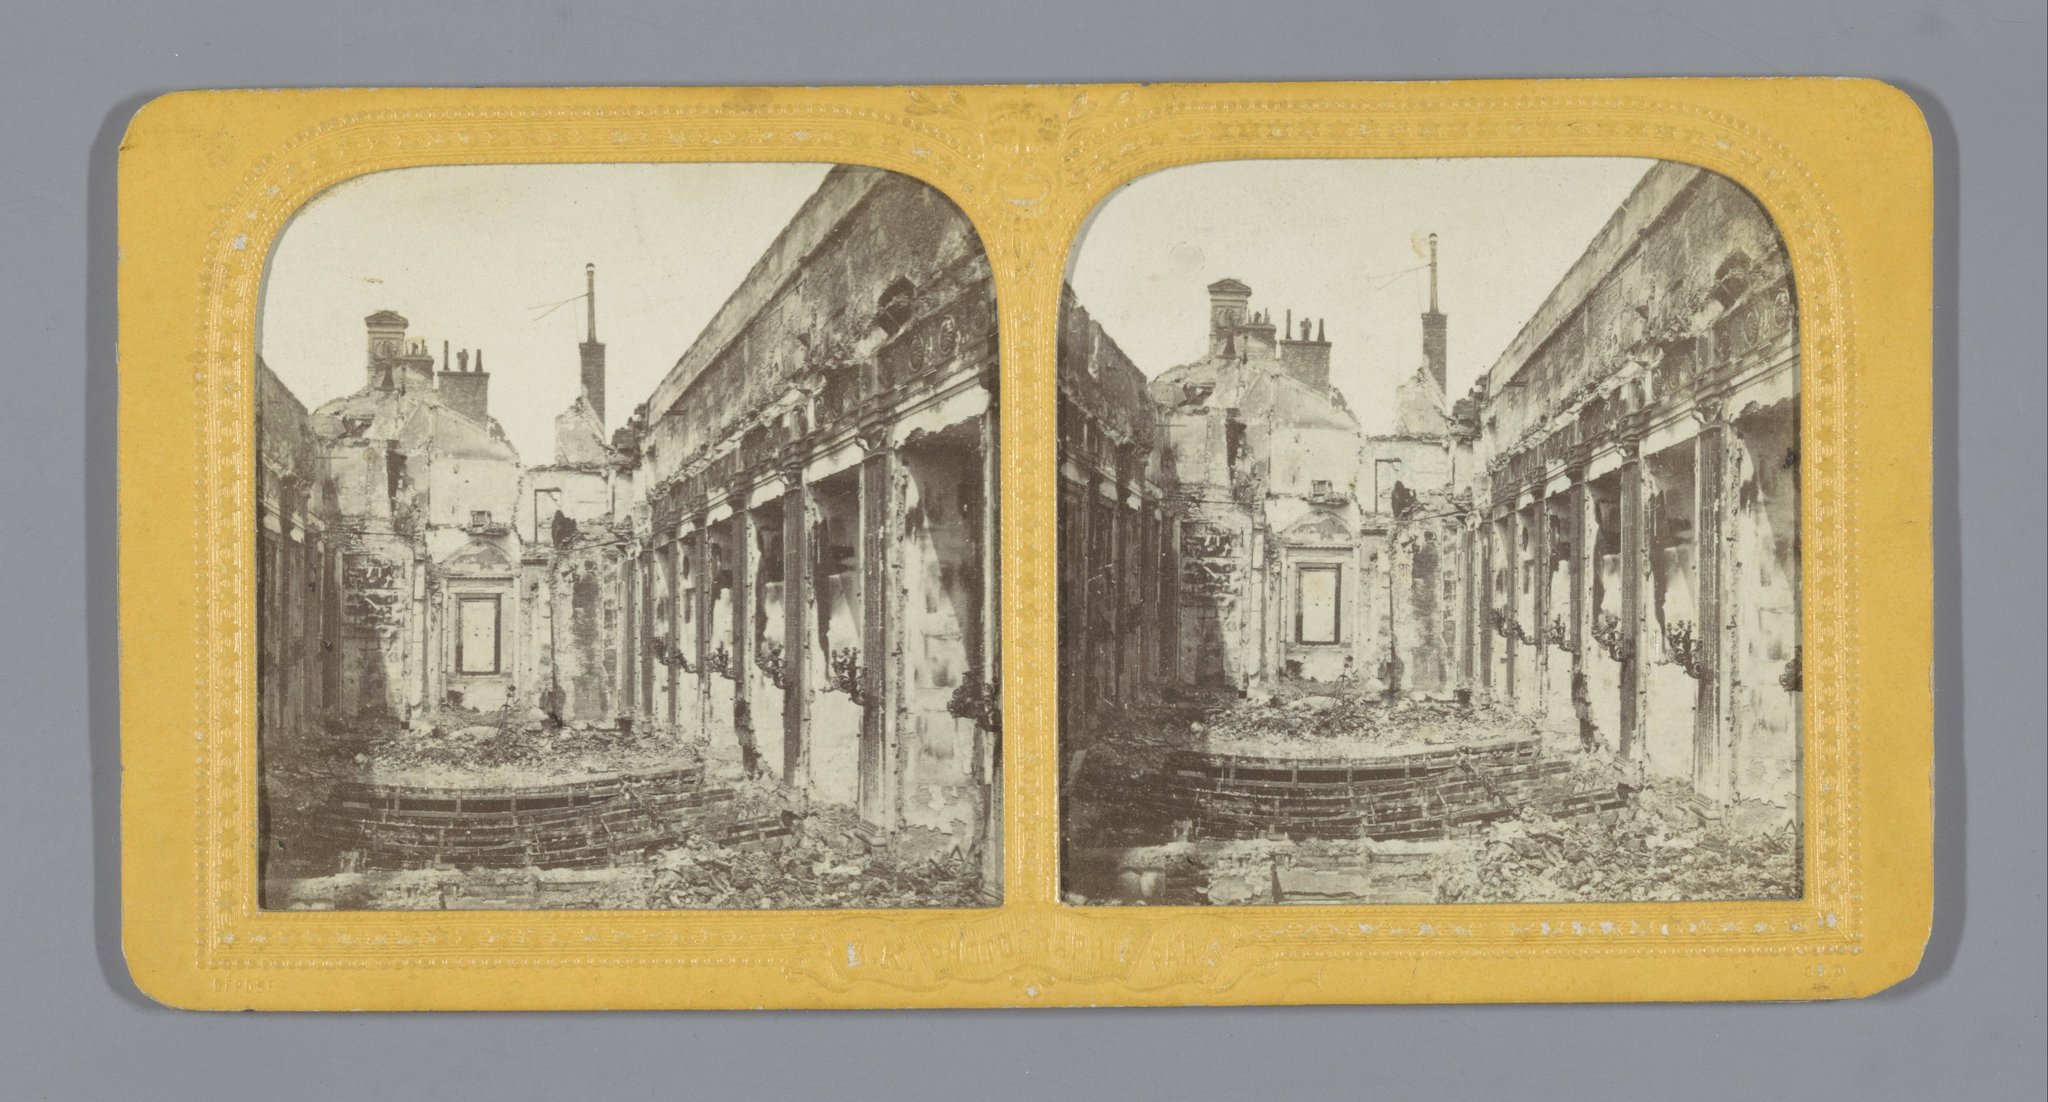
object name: tissue stereograph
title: Palais des Tuileries, Galeries de la Paix, Paris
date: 1871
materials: cardboard, paper, photographic support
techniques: albumen print, cutting, hand coloring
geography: paris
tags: gallery (spacious corridor), devastated, ruined place or city (~ warfare), tuileries palace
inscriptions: inscription: ‘Déposé’, inscription: ‘Ch D’, check stamp: ‘B.K. PHOTOGRAPHIE PARIS’